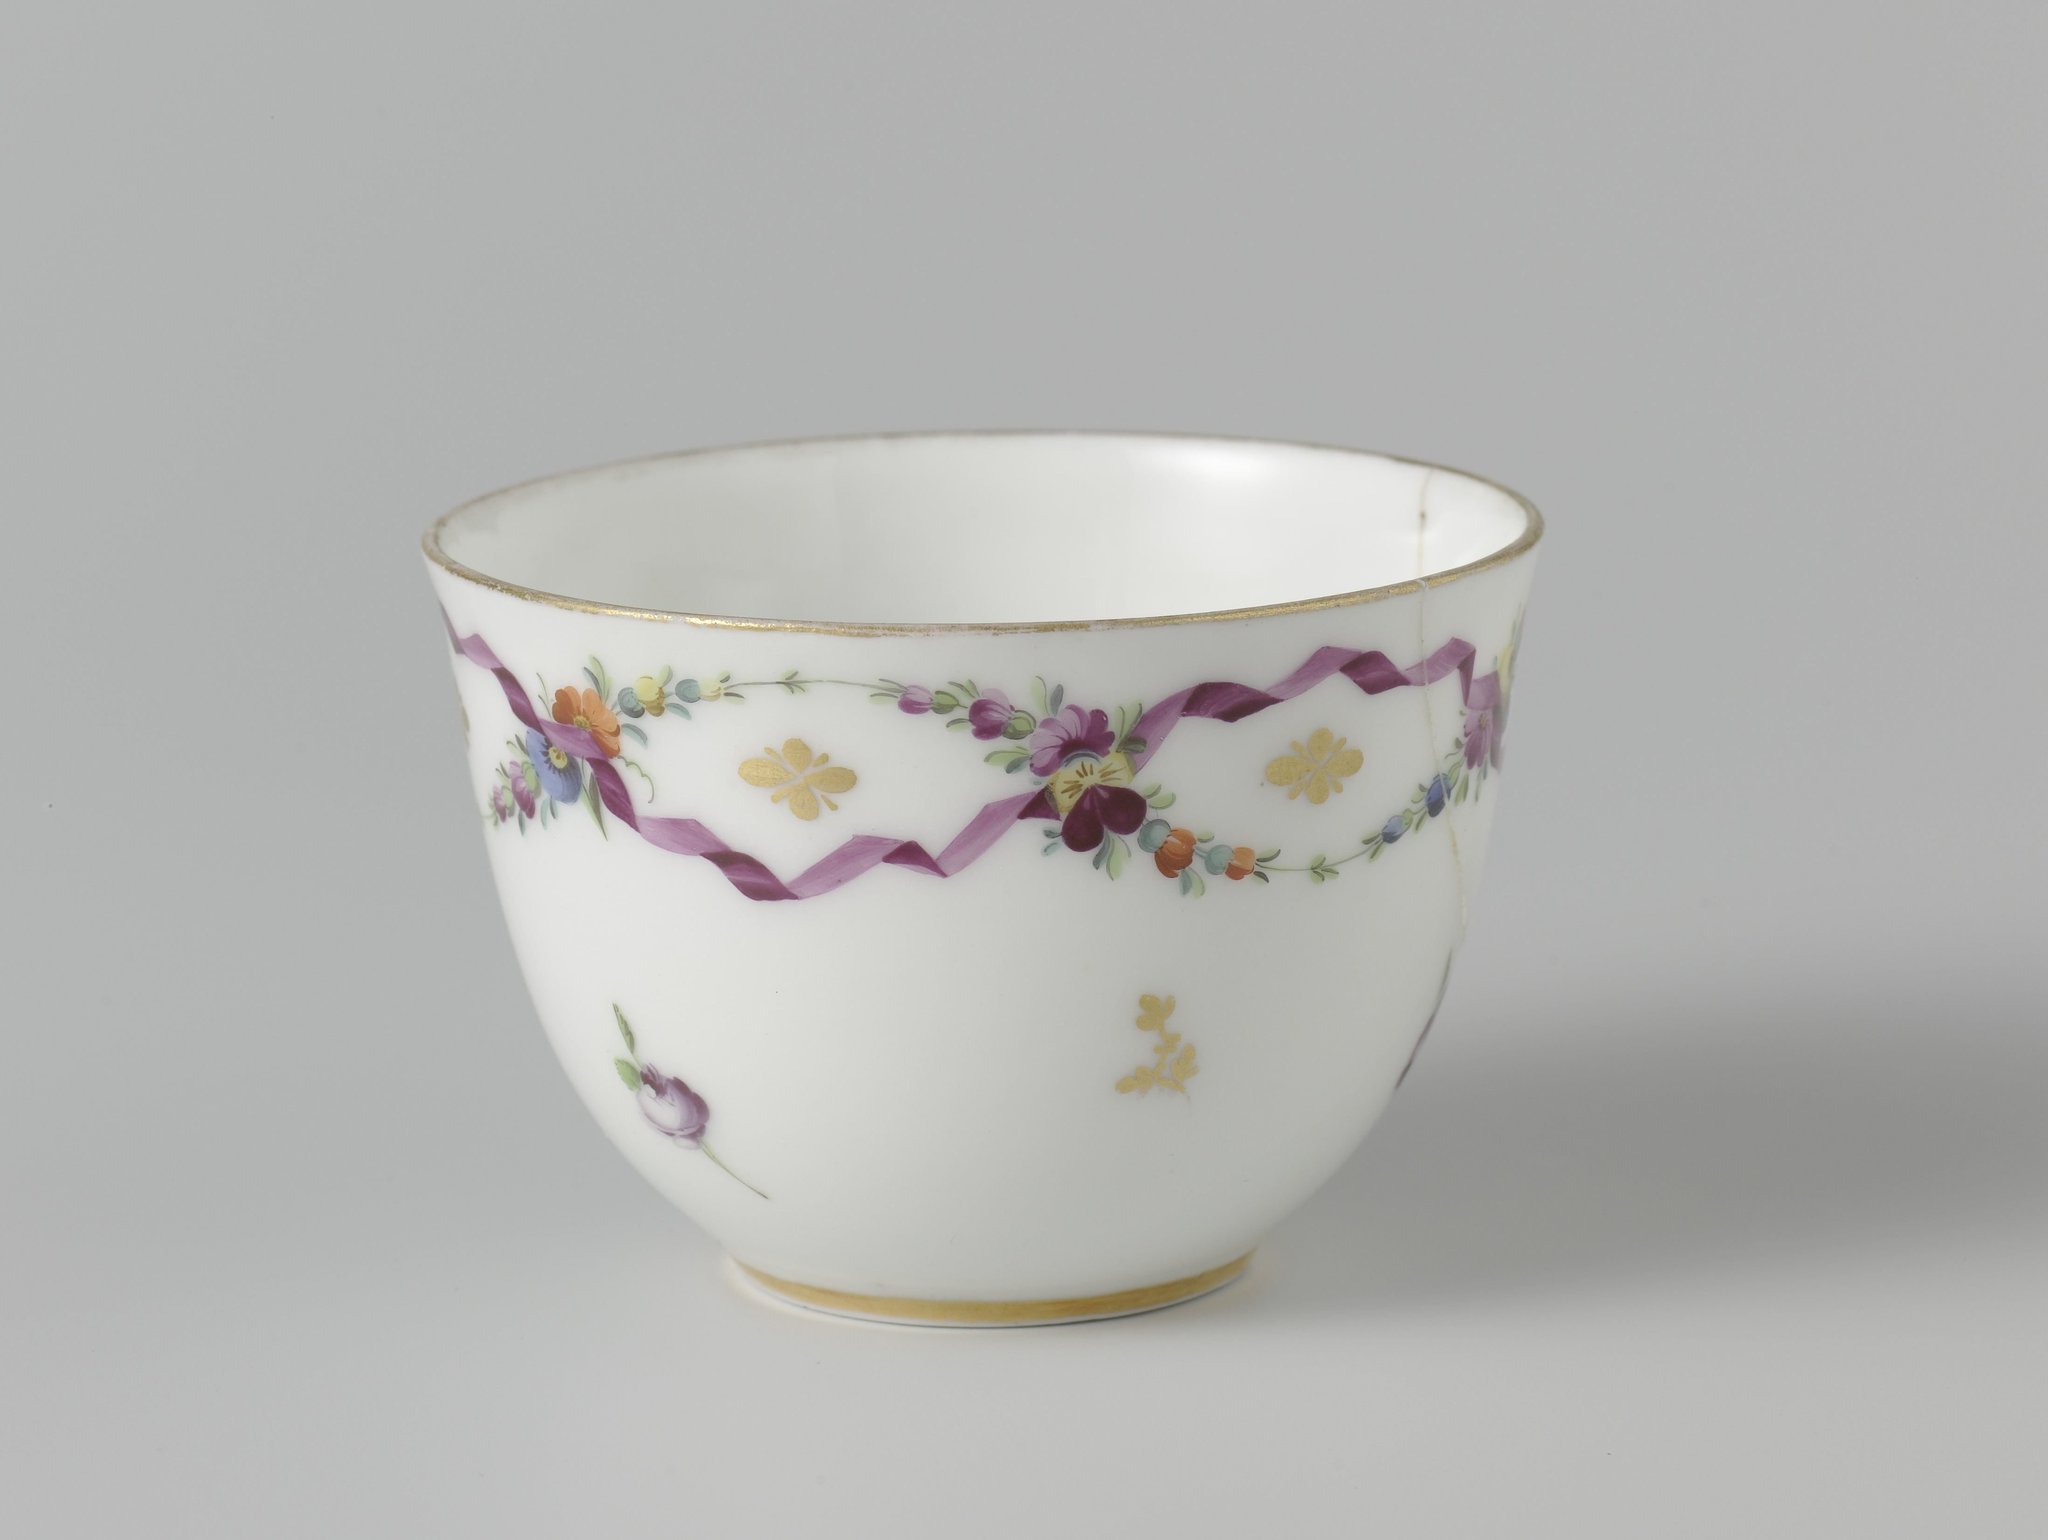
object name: cup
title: Kop zonder oor, beschilderd met strooibloemen en gouden lovertjes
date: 1809-1814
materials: porcelain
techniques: painted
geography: nieuwer-amstel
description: Tea service. Porcelain. Ouder-Amstel, c. 1790 - 1800. Factory under the direction of Friedrich Daeuber. Given by Mr and Mrs J.F. Heijbroek-Leendertz, 1985.